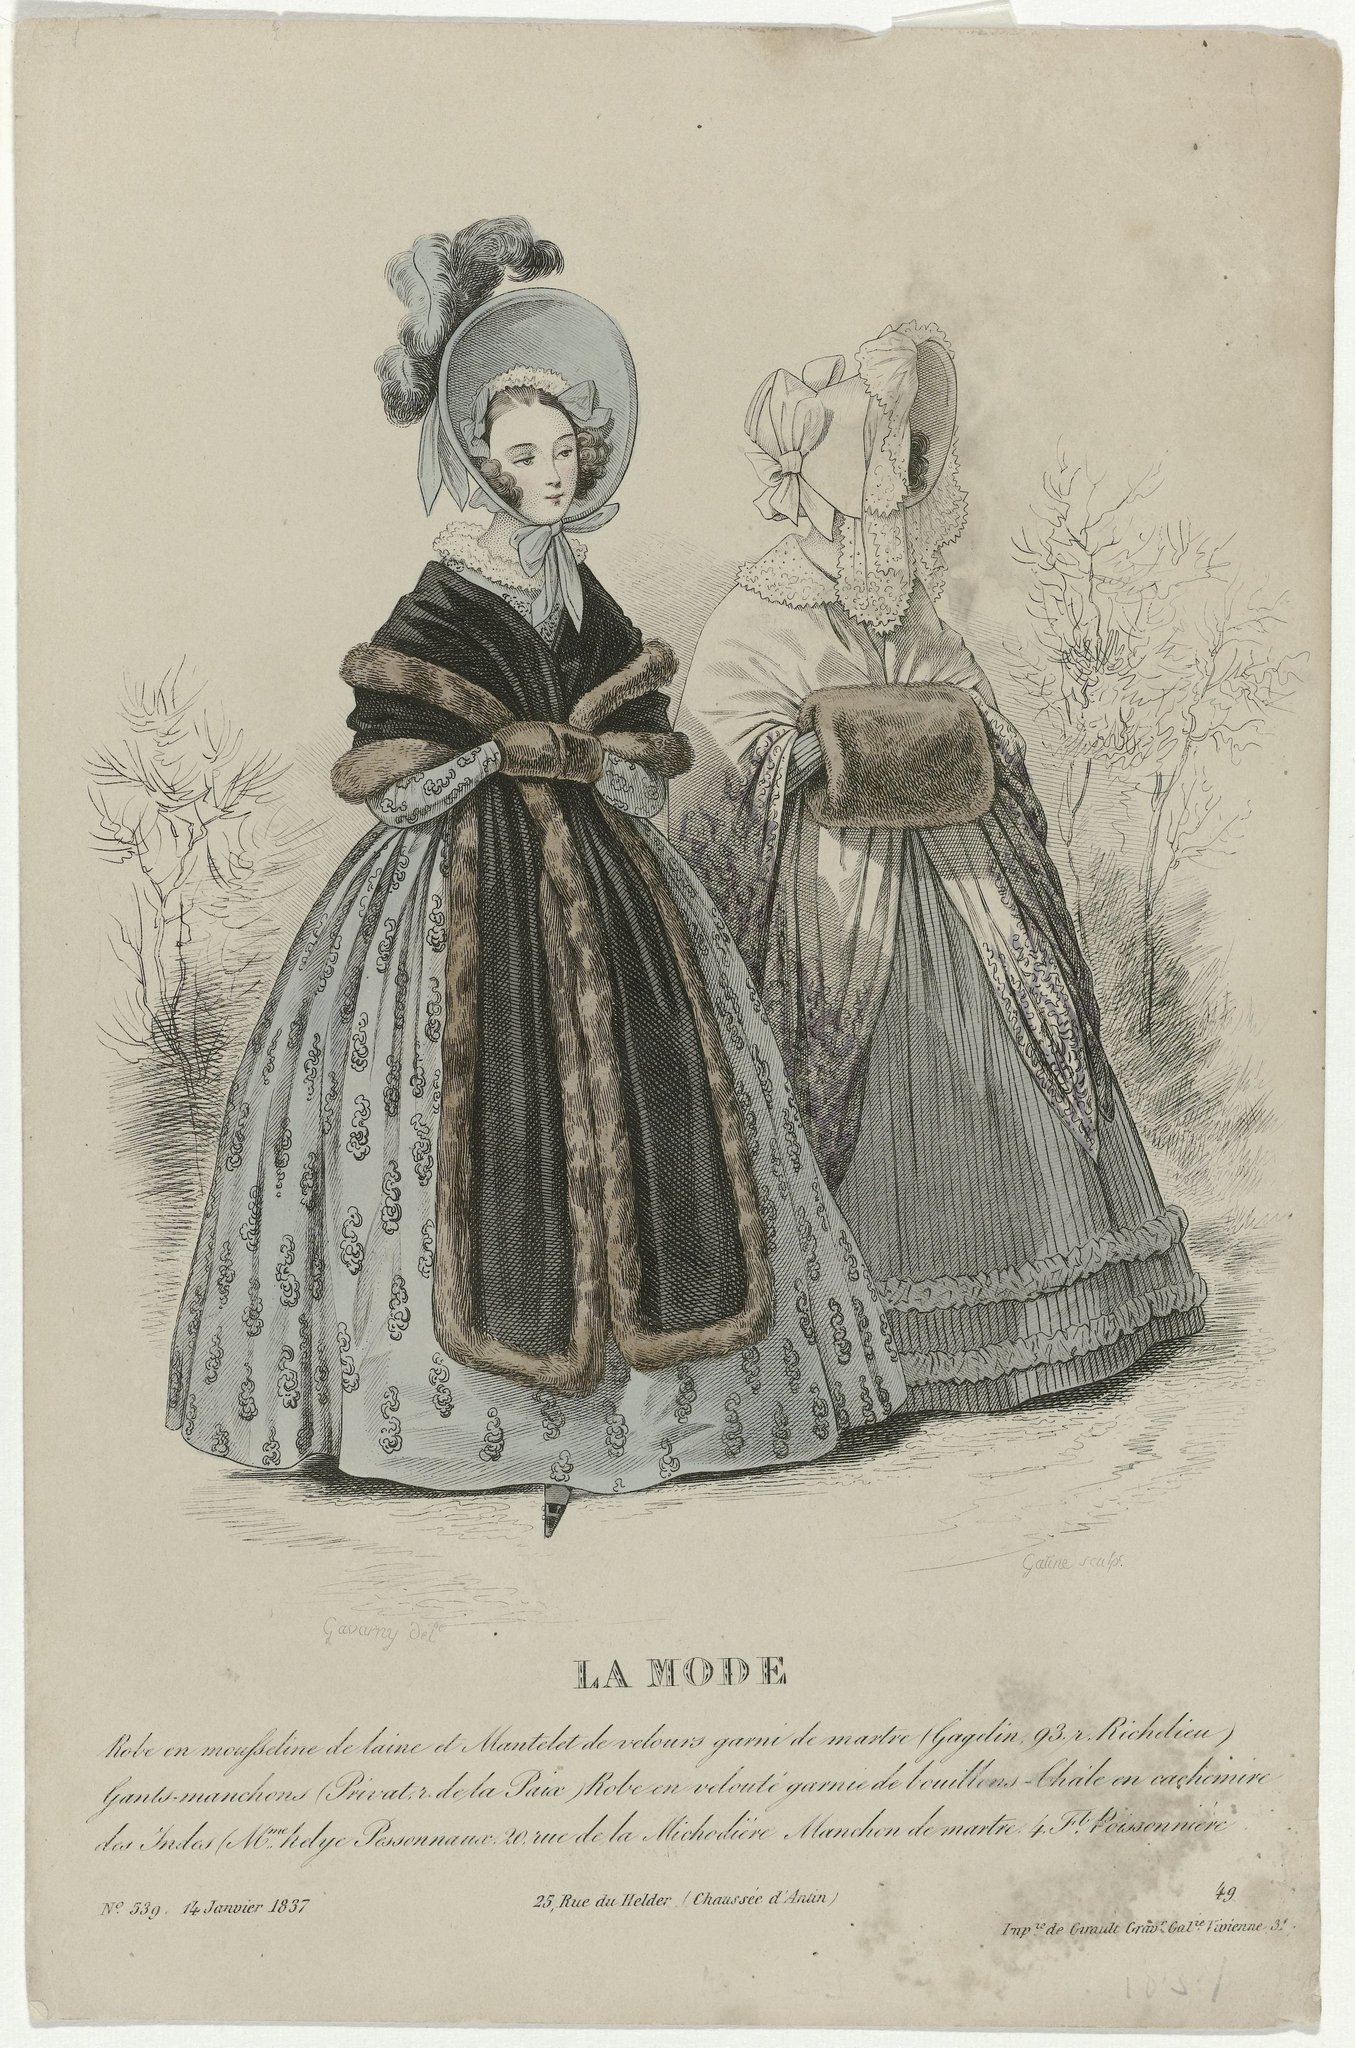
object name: fashion print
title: La Mode, 14 janvier 1837, Pl. 539 : Robe en mousseline de lain (...)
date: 1837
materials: paper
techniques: engraving, etching, hand coloring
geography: paris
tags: clothing for the upper part of the body (shawl) (+ women's clothes), gloves, mittens, etc. (+ fur used for clothes), clothing for the upper part of the body (mantelet) (+ women's clothes), fashion plates, head-gear: hat (+ women's clothes), shoes, sandals (+ women's clothes), dress, gown (+ women's clothes), muff (+ fur used for clothes)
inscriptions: address: ‘25, Rue du Helder ( Chaussée d'Antin )’, caption: ‘Robe en mousseline de laine et Mantelet de velours garni de martre (Gagelin 93.r. Richelieu) Gants-manchons (Privat,r. de la Paix) Robe en velouté garni de bouillons - Châle en cachemire des Indes (M"me Helye Pessonnaux.20.rue de la Michodi're Manchon de martre.4. Fb. Poissonniére.’, title: ‘La Mode.’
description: Japon van Wollen mousseline en een kleine schoudermantel van fluweel afgezet met marterbont van Gagelin. 'Gants-manchons' of handmoffen(?) van Privat. Japon van 'velouté' versierd met 'bouillons'. Sjaal van 'cachemire des Indes' van Helye Pessonnaux. Mof van marterbont. Prent uit het modetijdschrift La Mode (1829-1855).